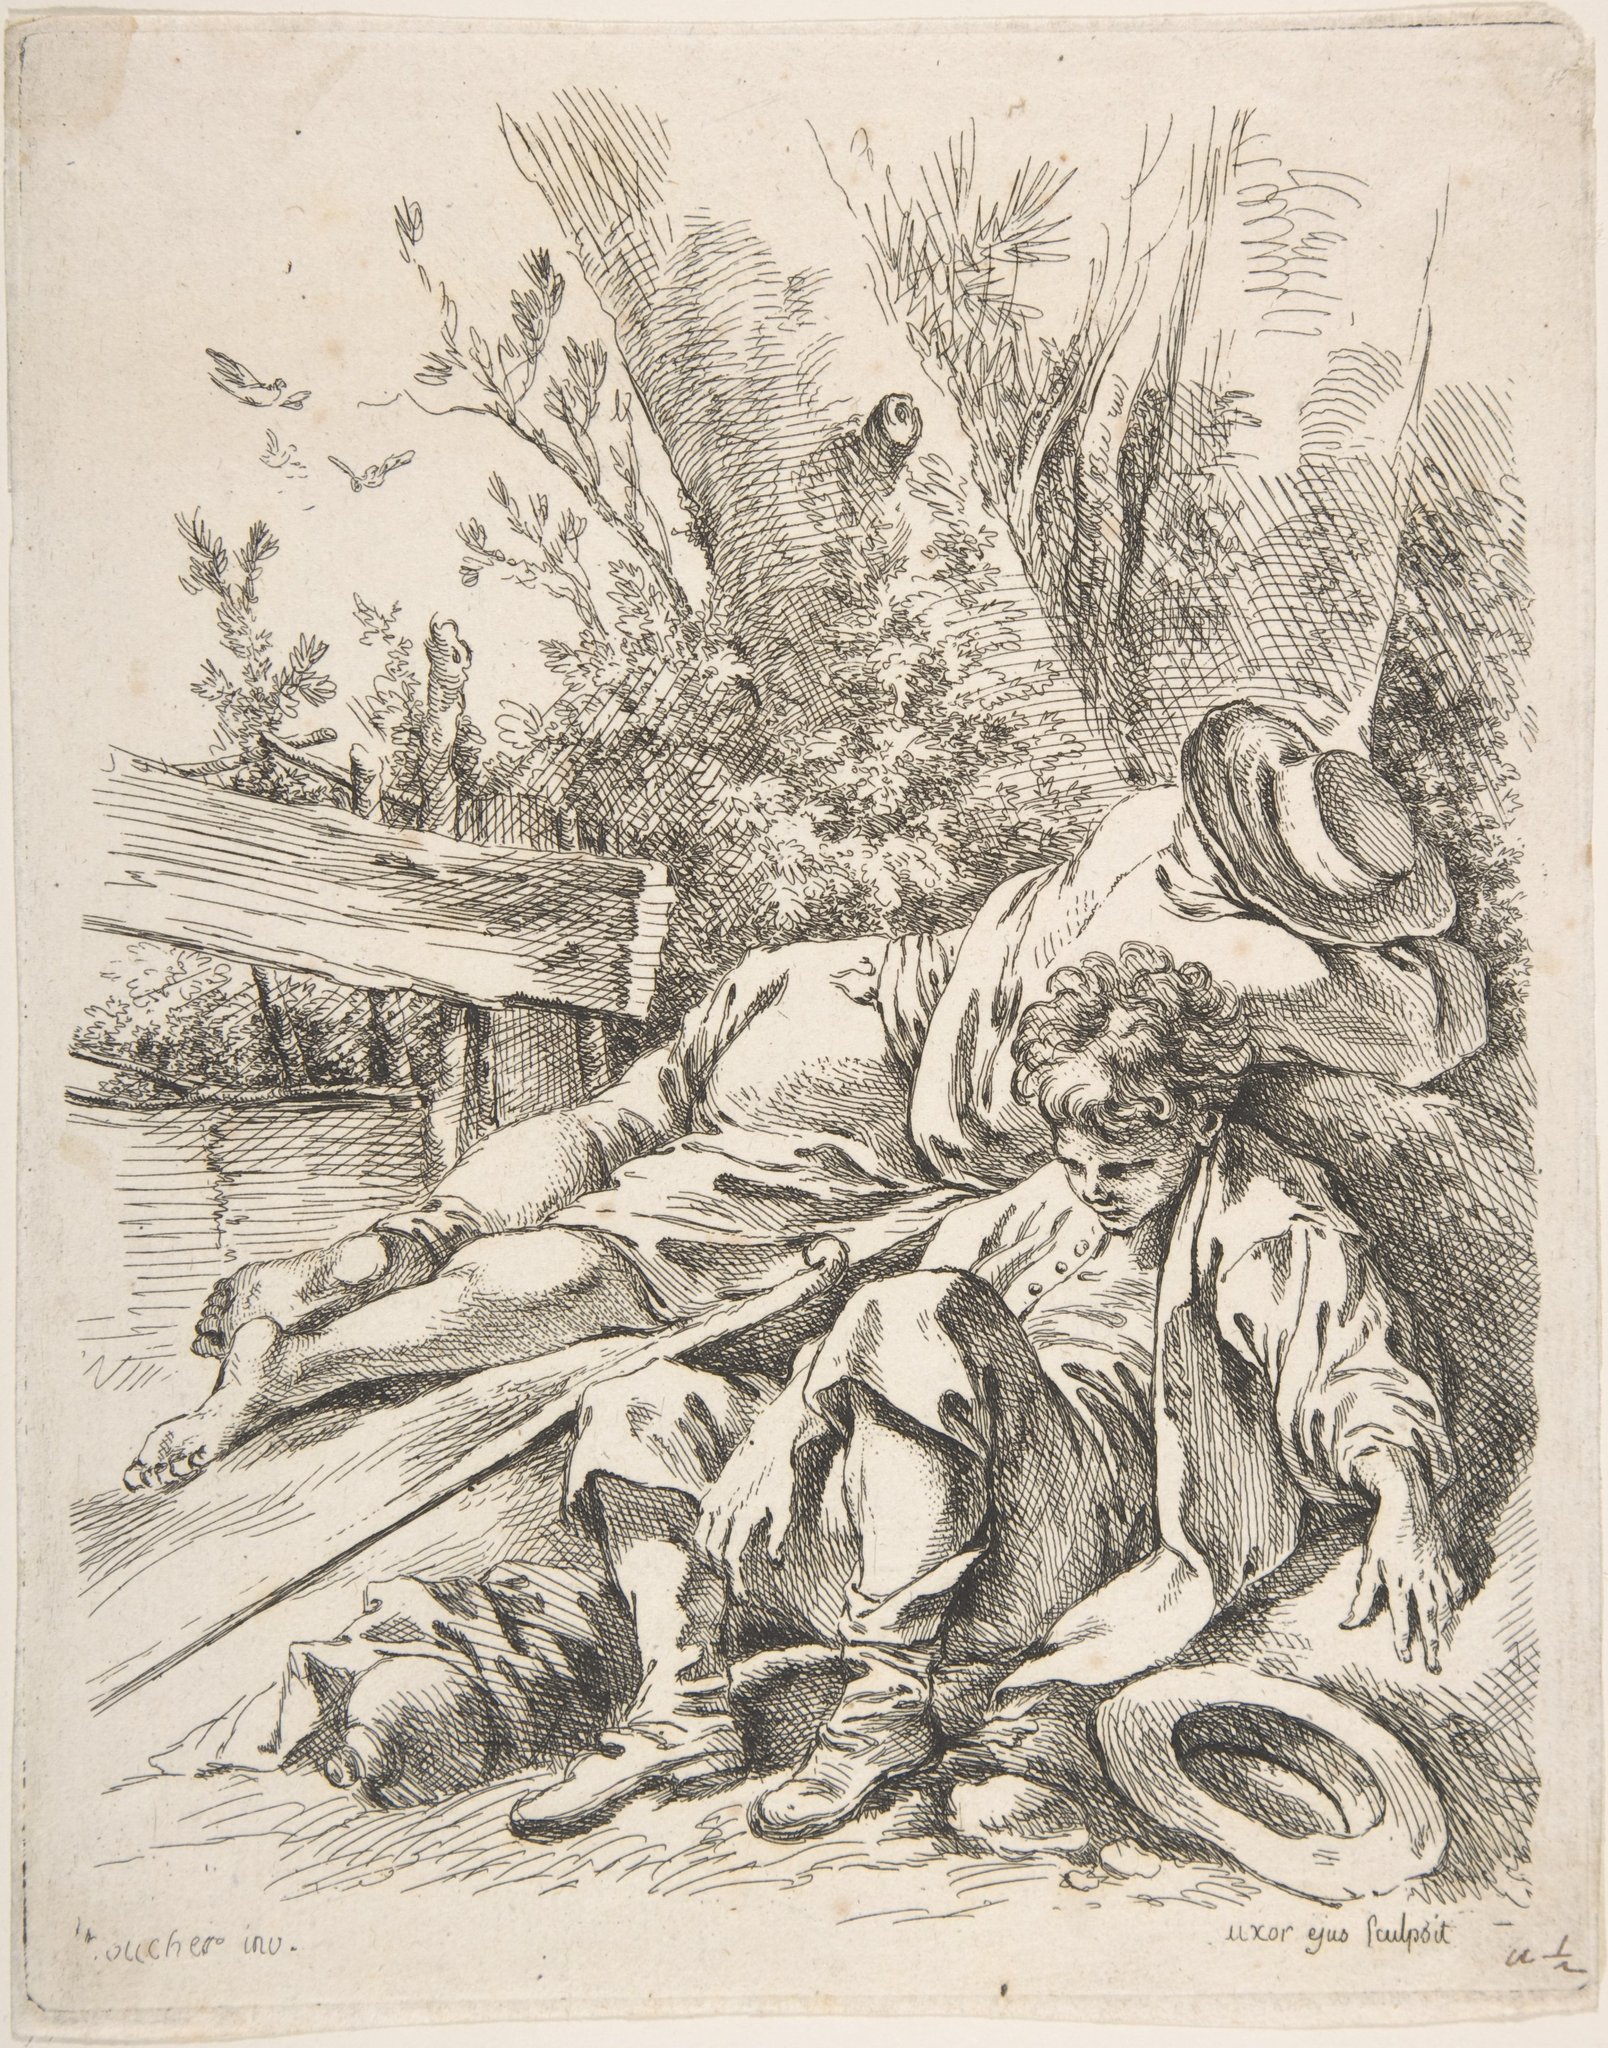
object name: print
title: Two Boys Sleeping Besides a Tree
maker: marie jeanne boucher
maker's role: artist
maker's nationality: french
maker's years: 1716-1785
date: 1750-1760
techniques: etching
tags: sleeping,boys